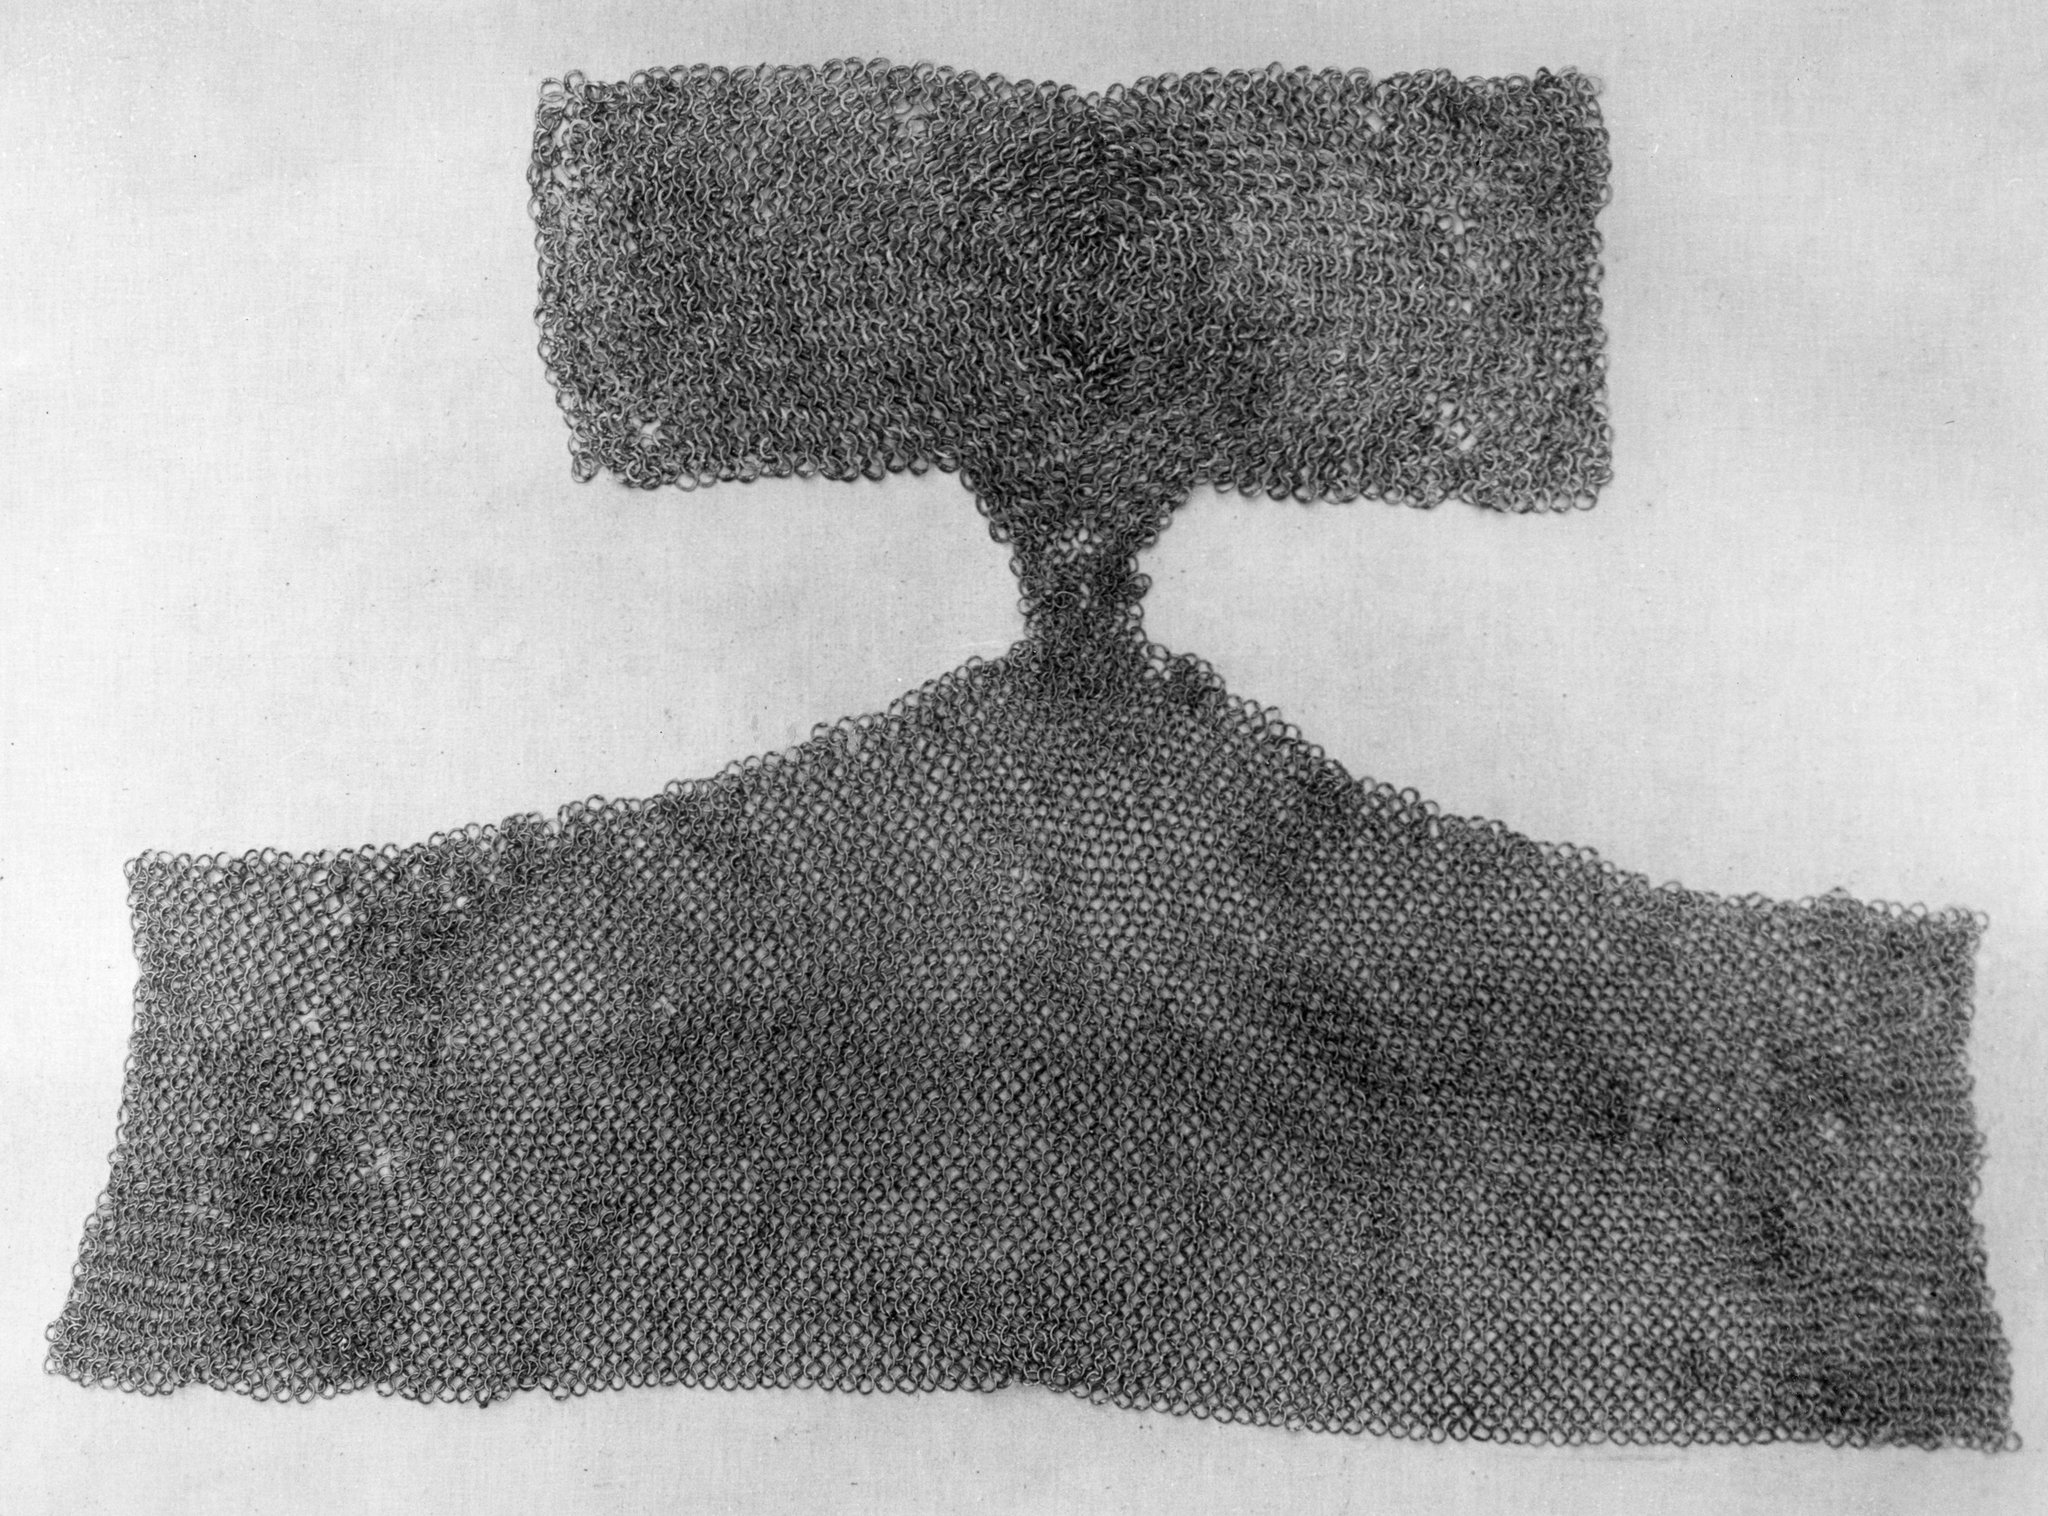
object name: brayette and buttock defense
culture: german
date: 1501-1600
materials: steel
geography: germany